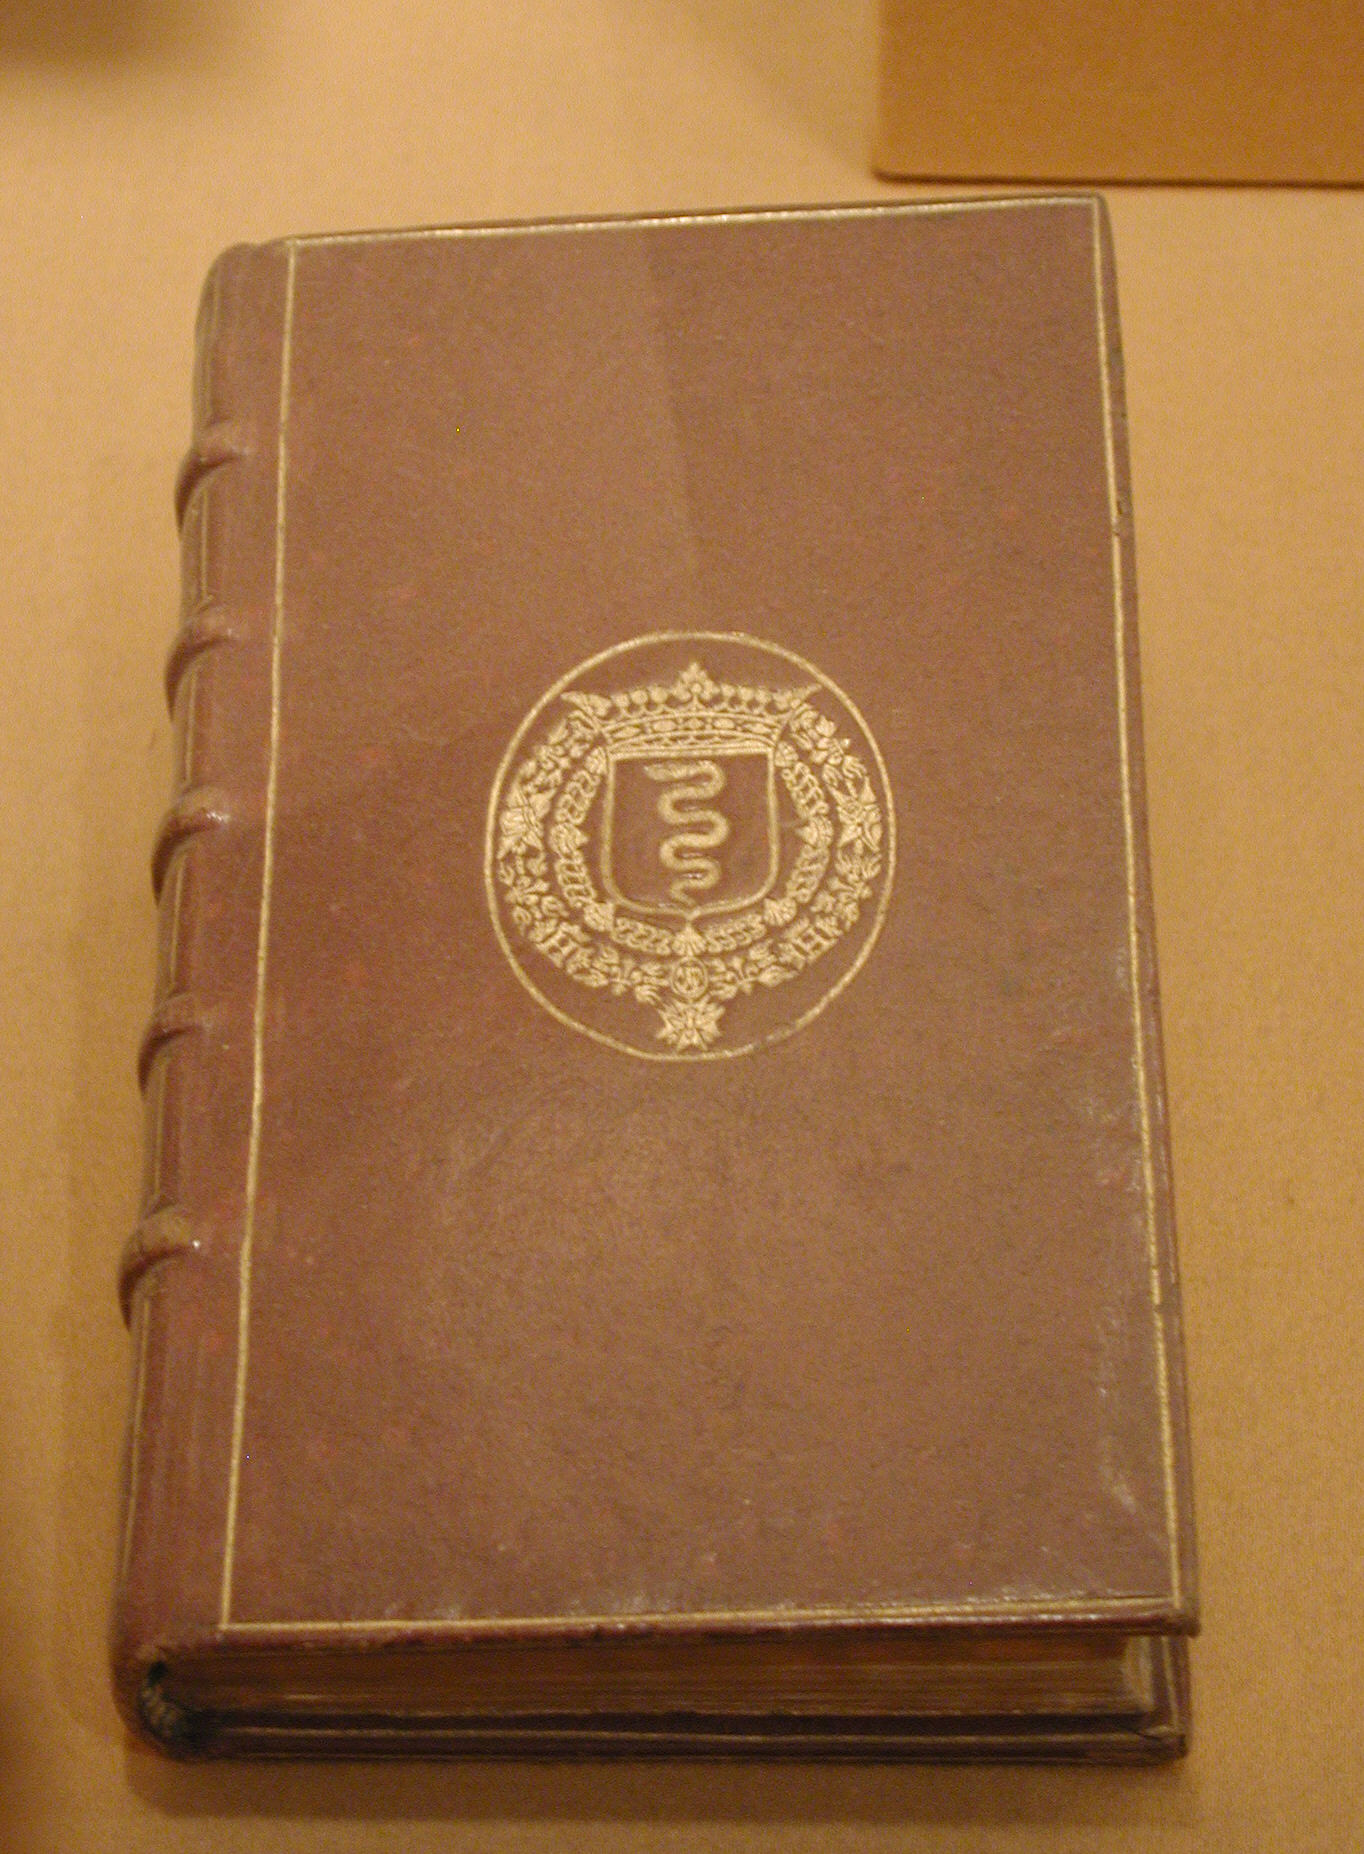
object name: book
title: Ordonnance de Louis XIV Pour Les Armées Navales et Arcenaux de Marine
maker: estiennes michallet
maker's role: publisher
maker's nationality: french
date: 1689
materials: gilt, leather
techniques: tooling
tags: coat of arms